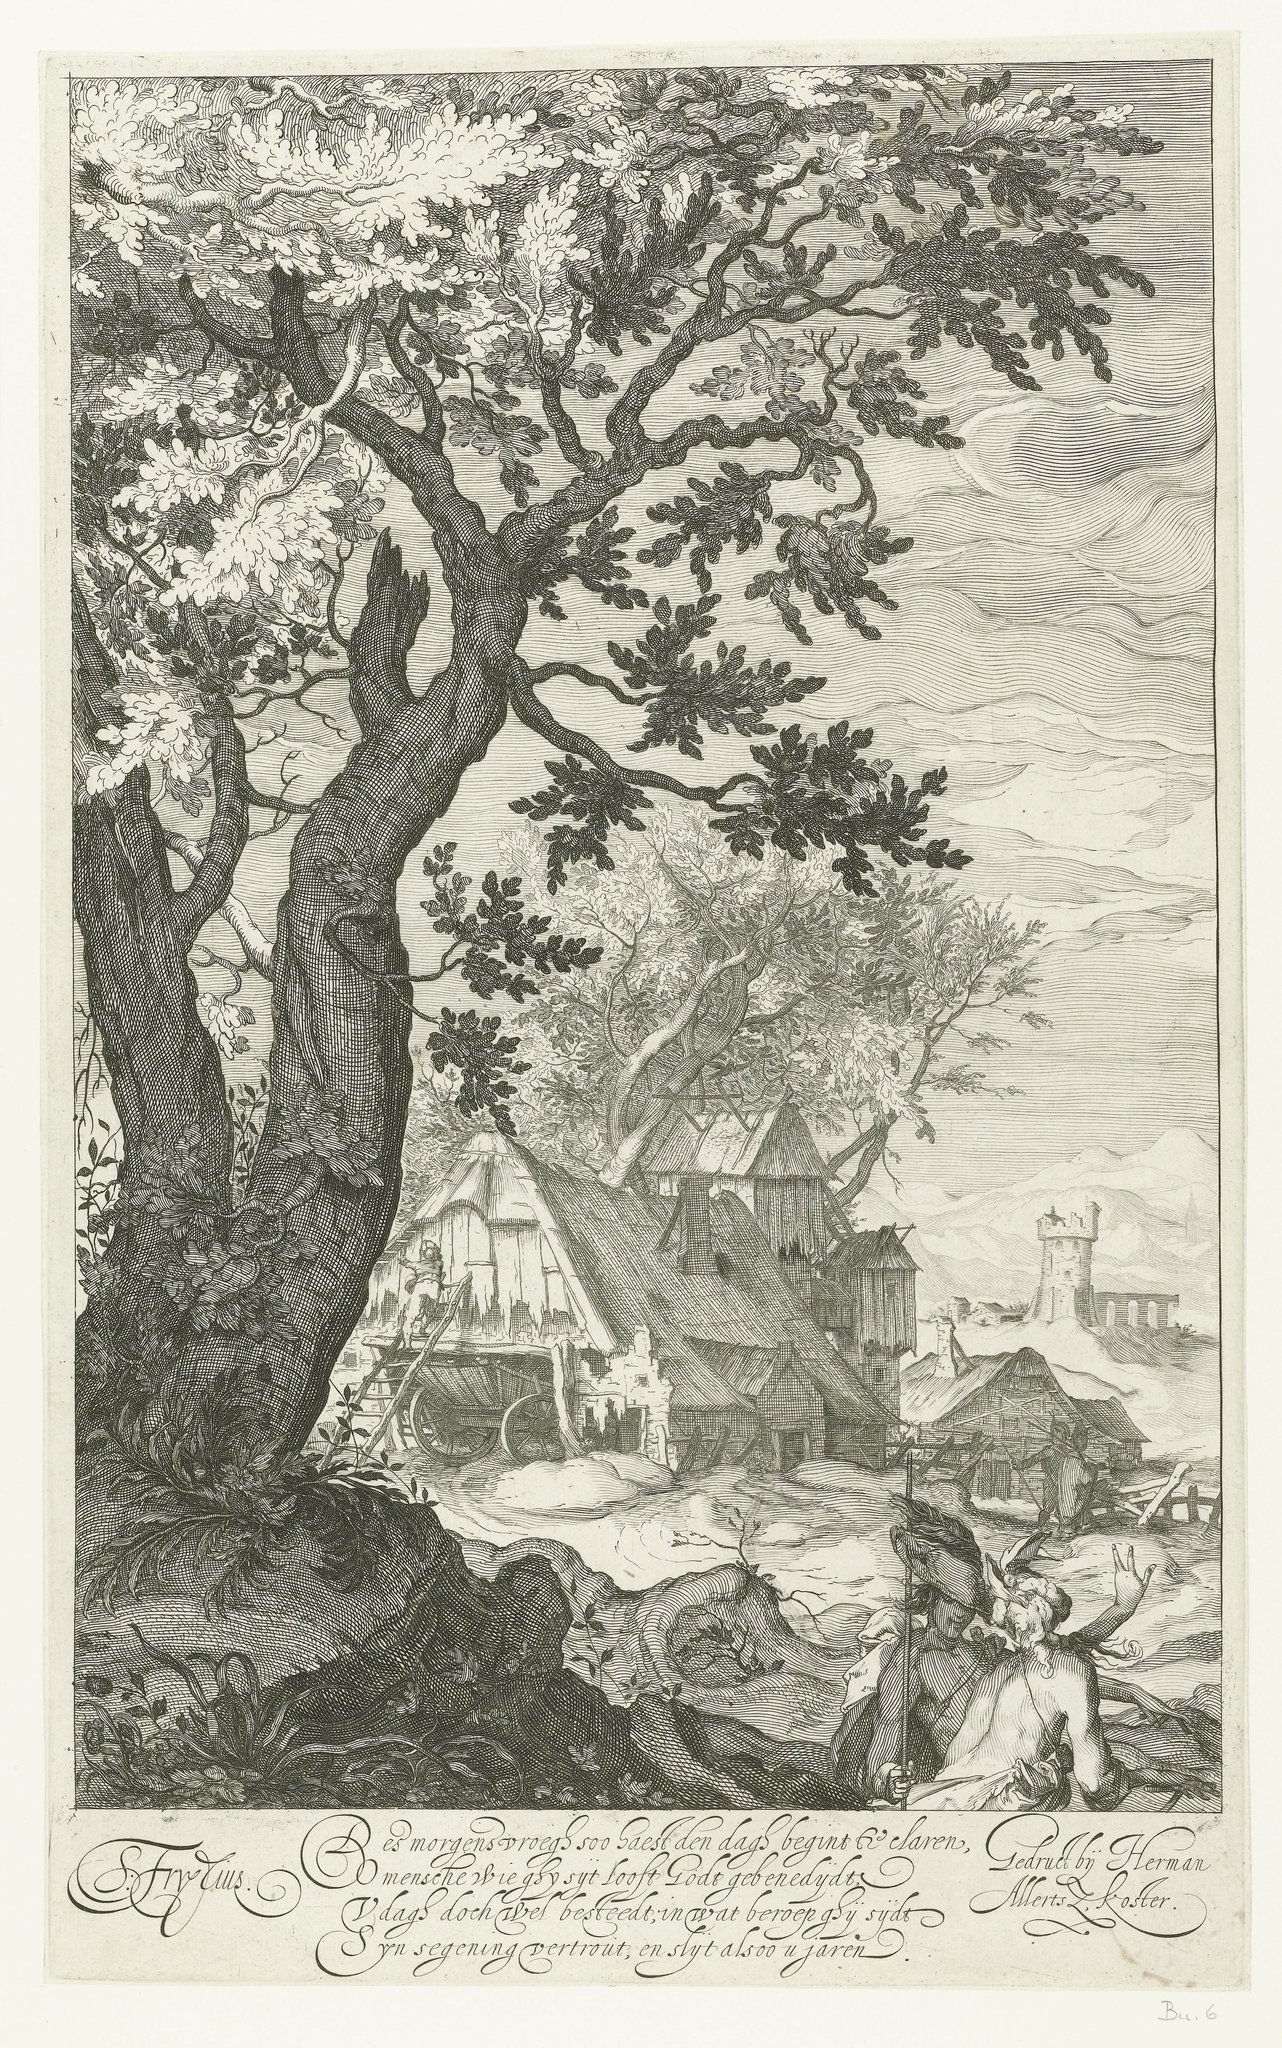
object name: print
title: Landschap met een boerderij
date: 1598-1616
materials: paper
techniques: etching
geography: northern netherlands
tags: farm or solitary house in landscape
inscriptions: collector's mark: Lugt 240